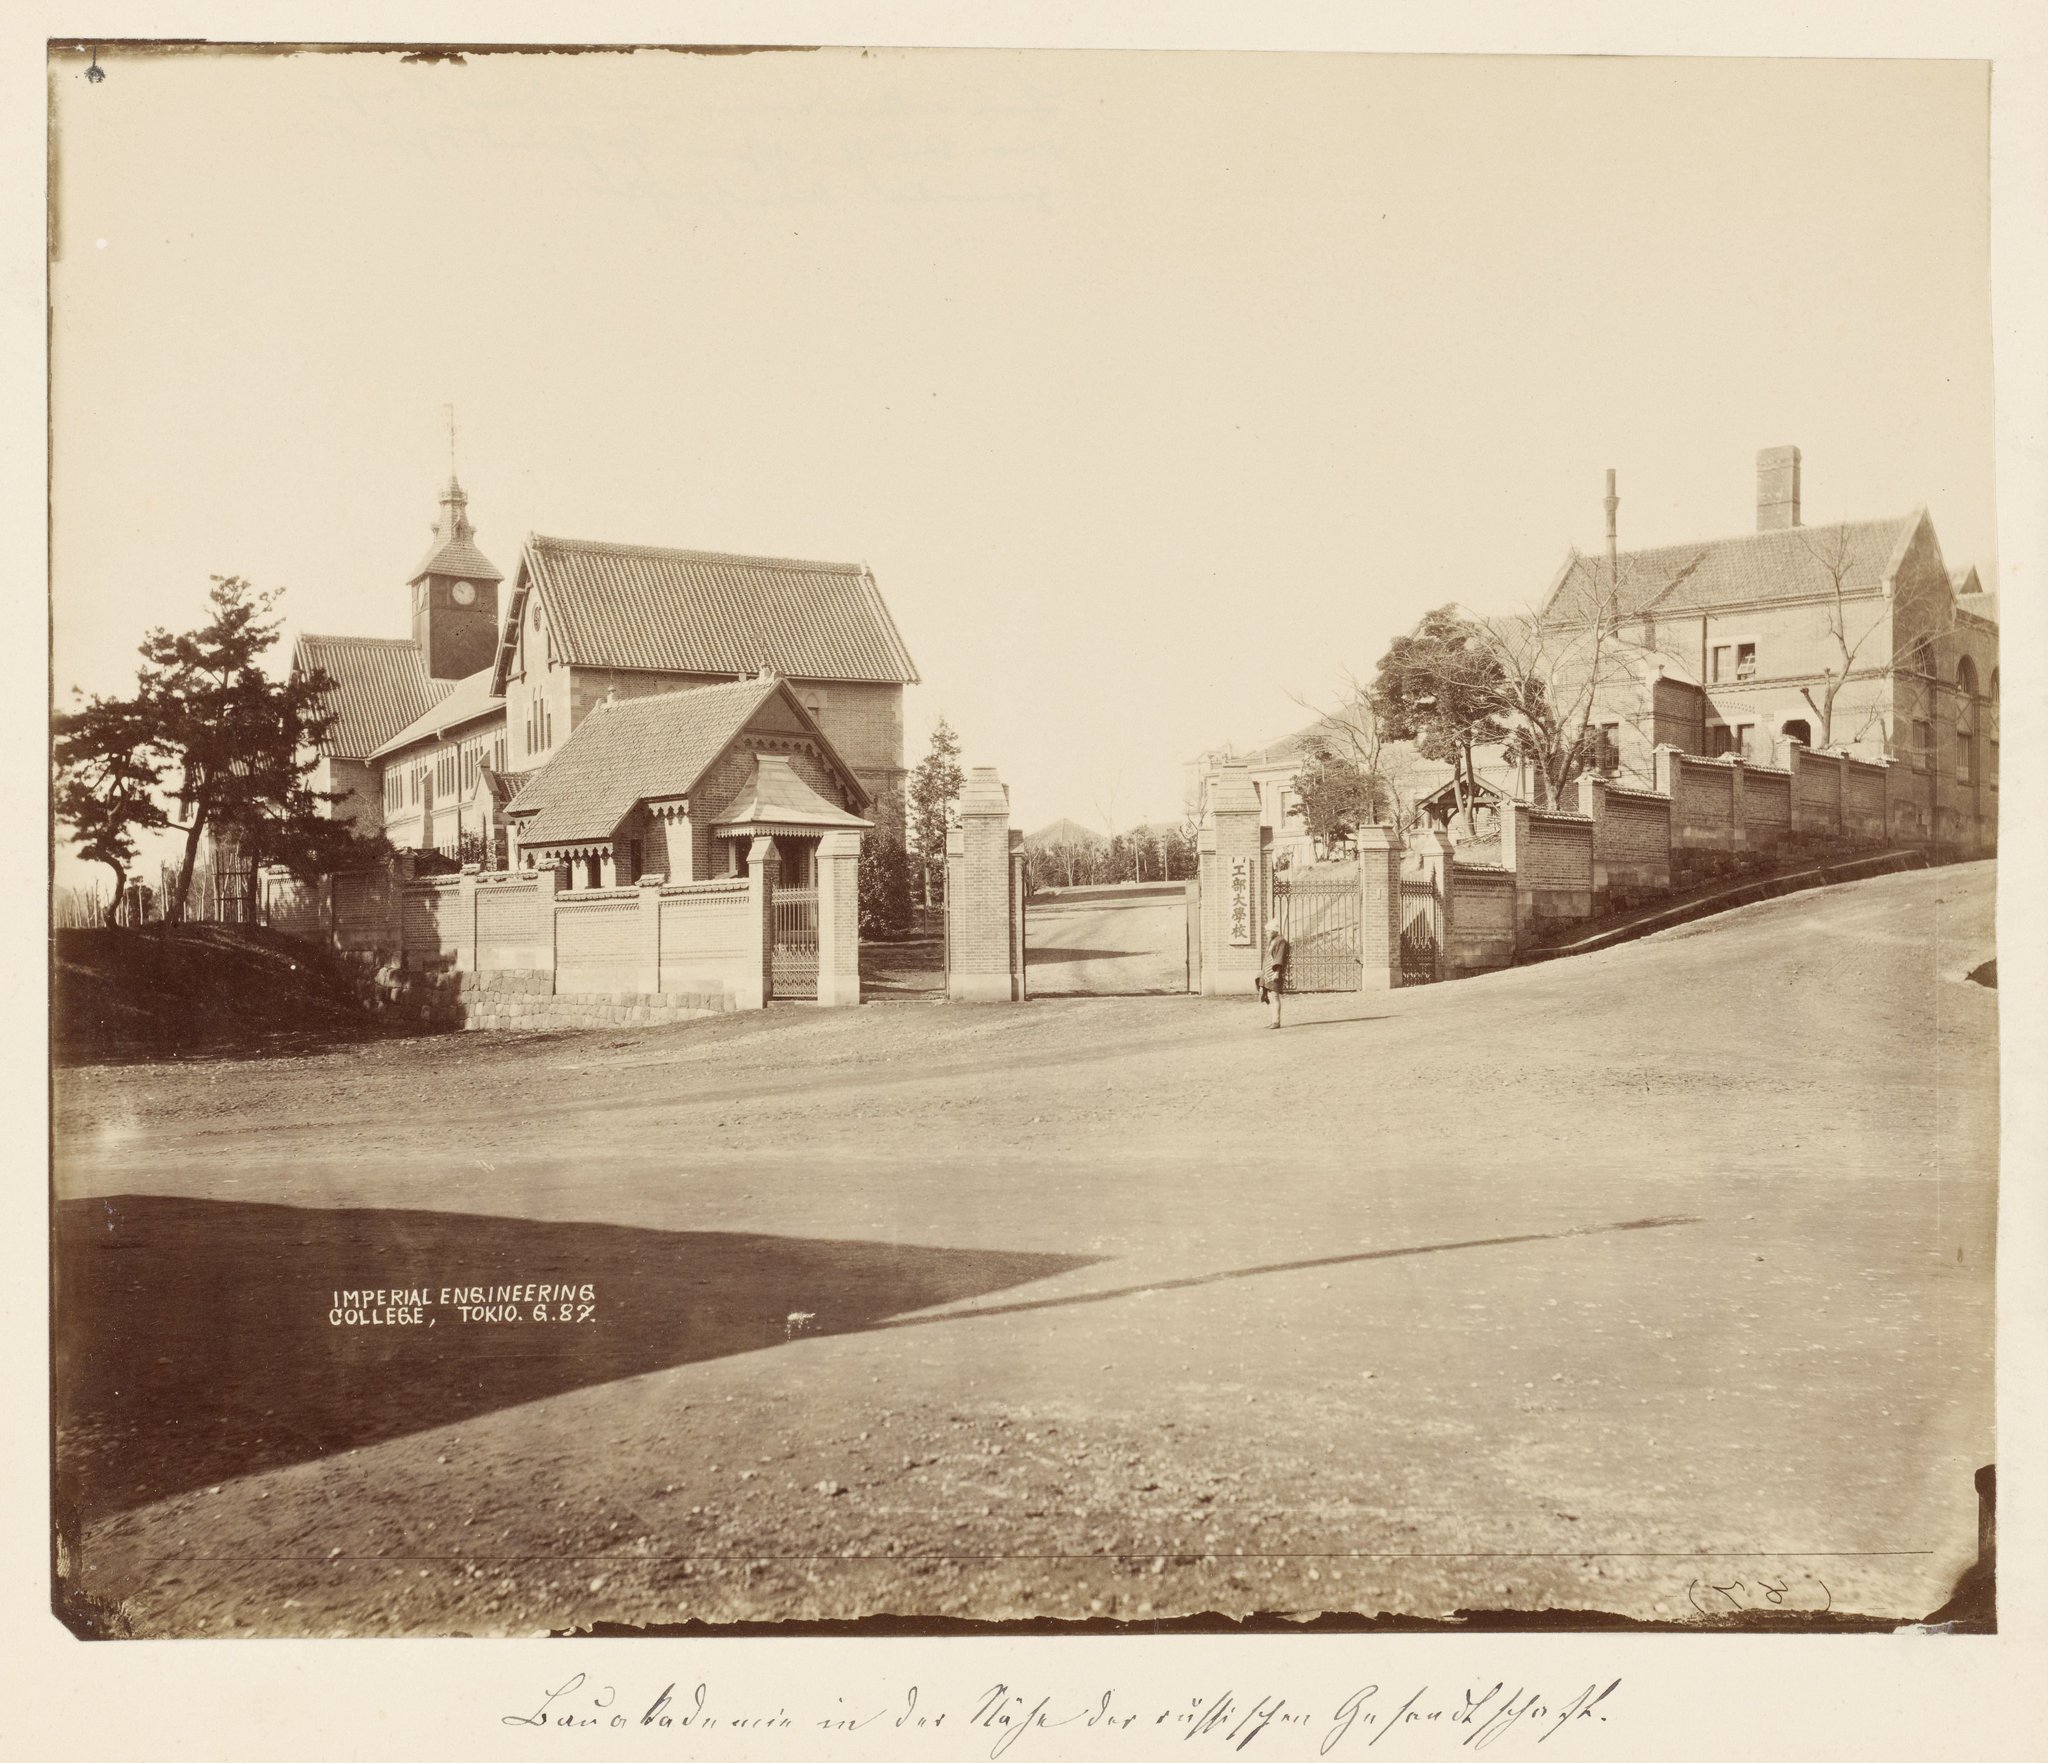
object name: photograph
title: Gezicht op het Imperial Engineering College in Tokyo, Japan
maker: Anonymous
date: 1884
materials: cardboard, paper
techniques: albumen print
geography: tokyo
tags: university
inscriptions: number: ‘G.87’, inscription: ‘[...] in der Nähe der [...]’